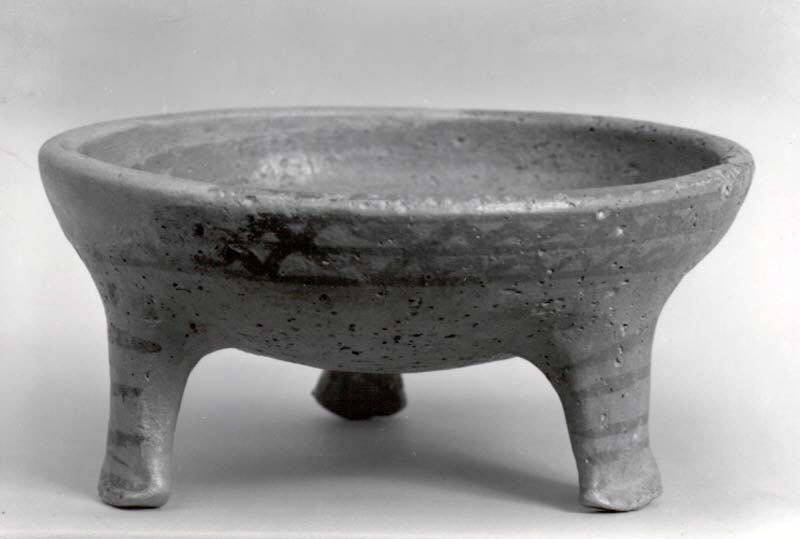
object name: bowl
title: Tripod bowl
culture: iranian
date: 2000-1600 BCE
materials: ceramic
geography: iran, luristan